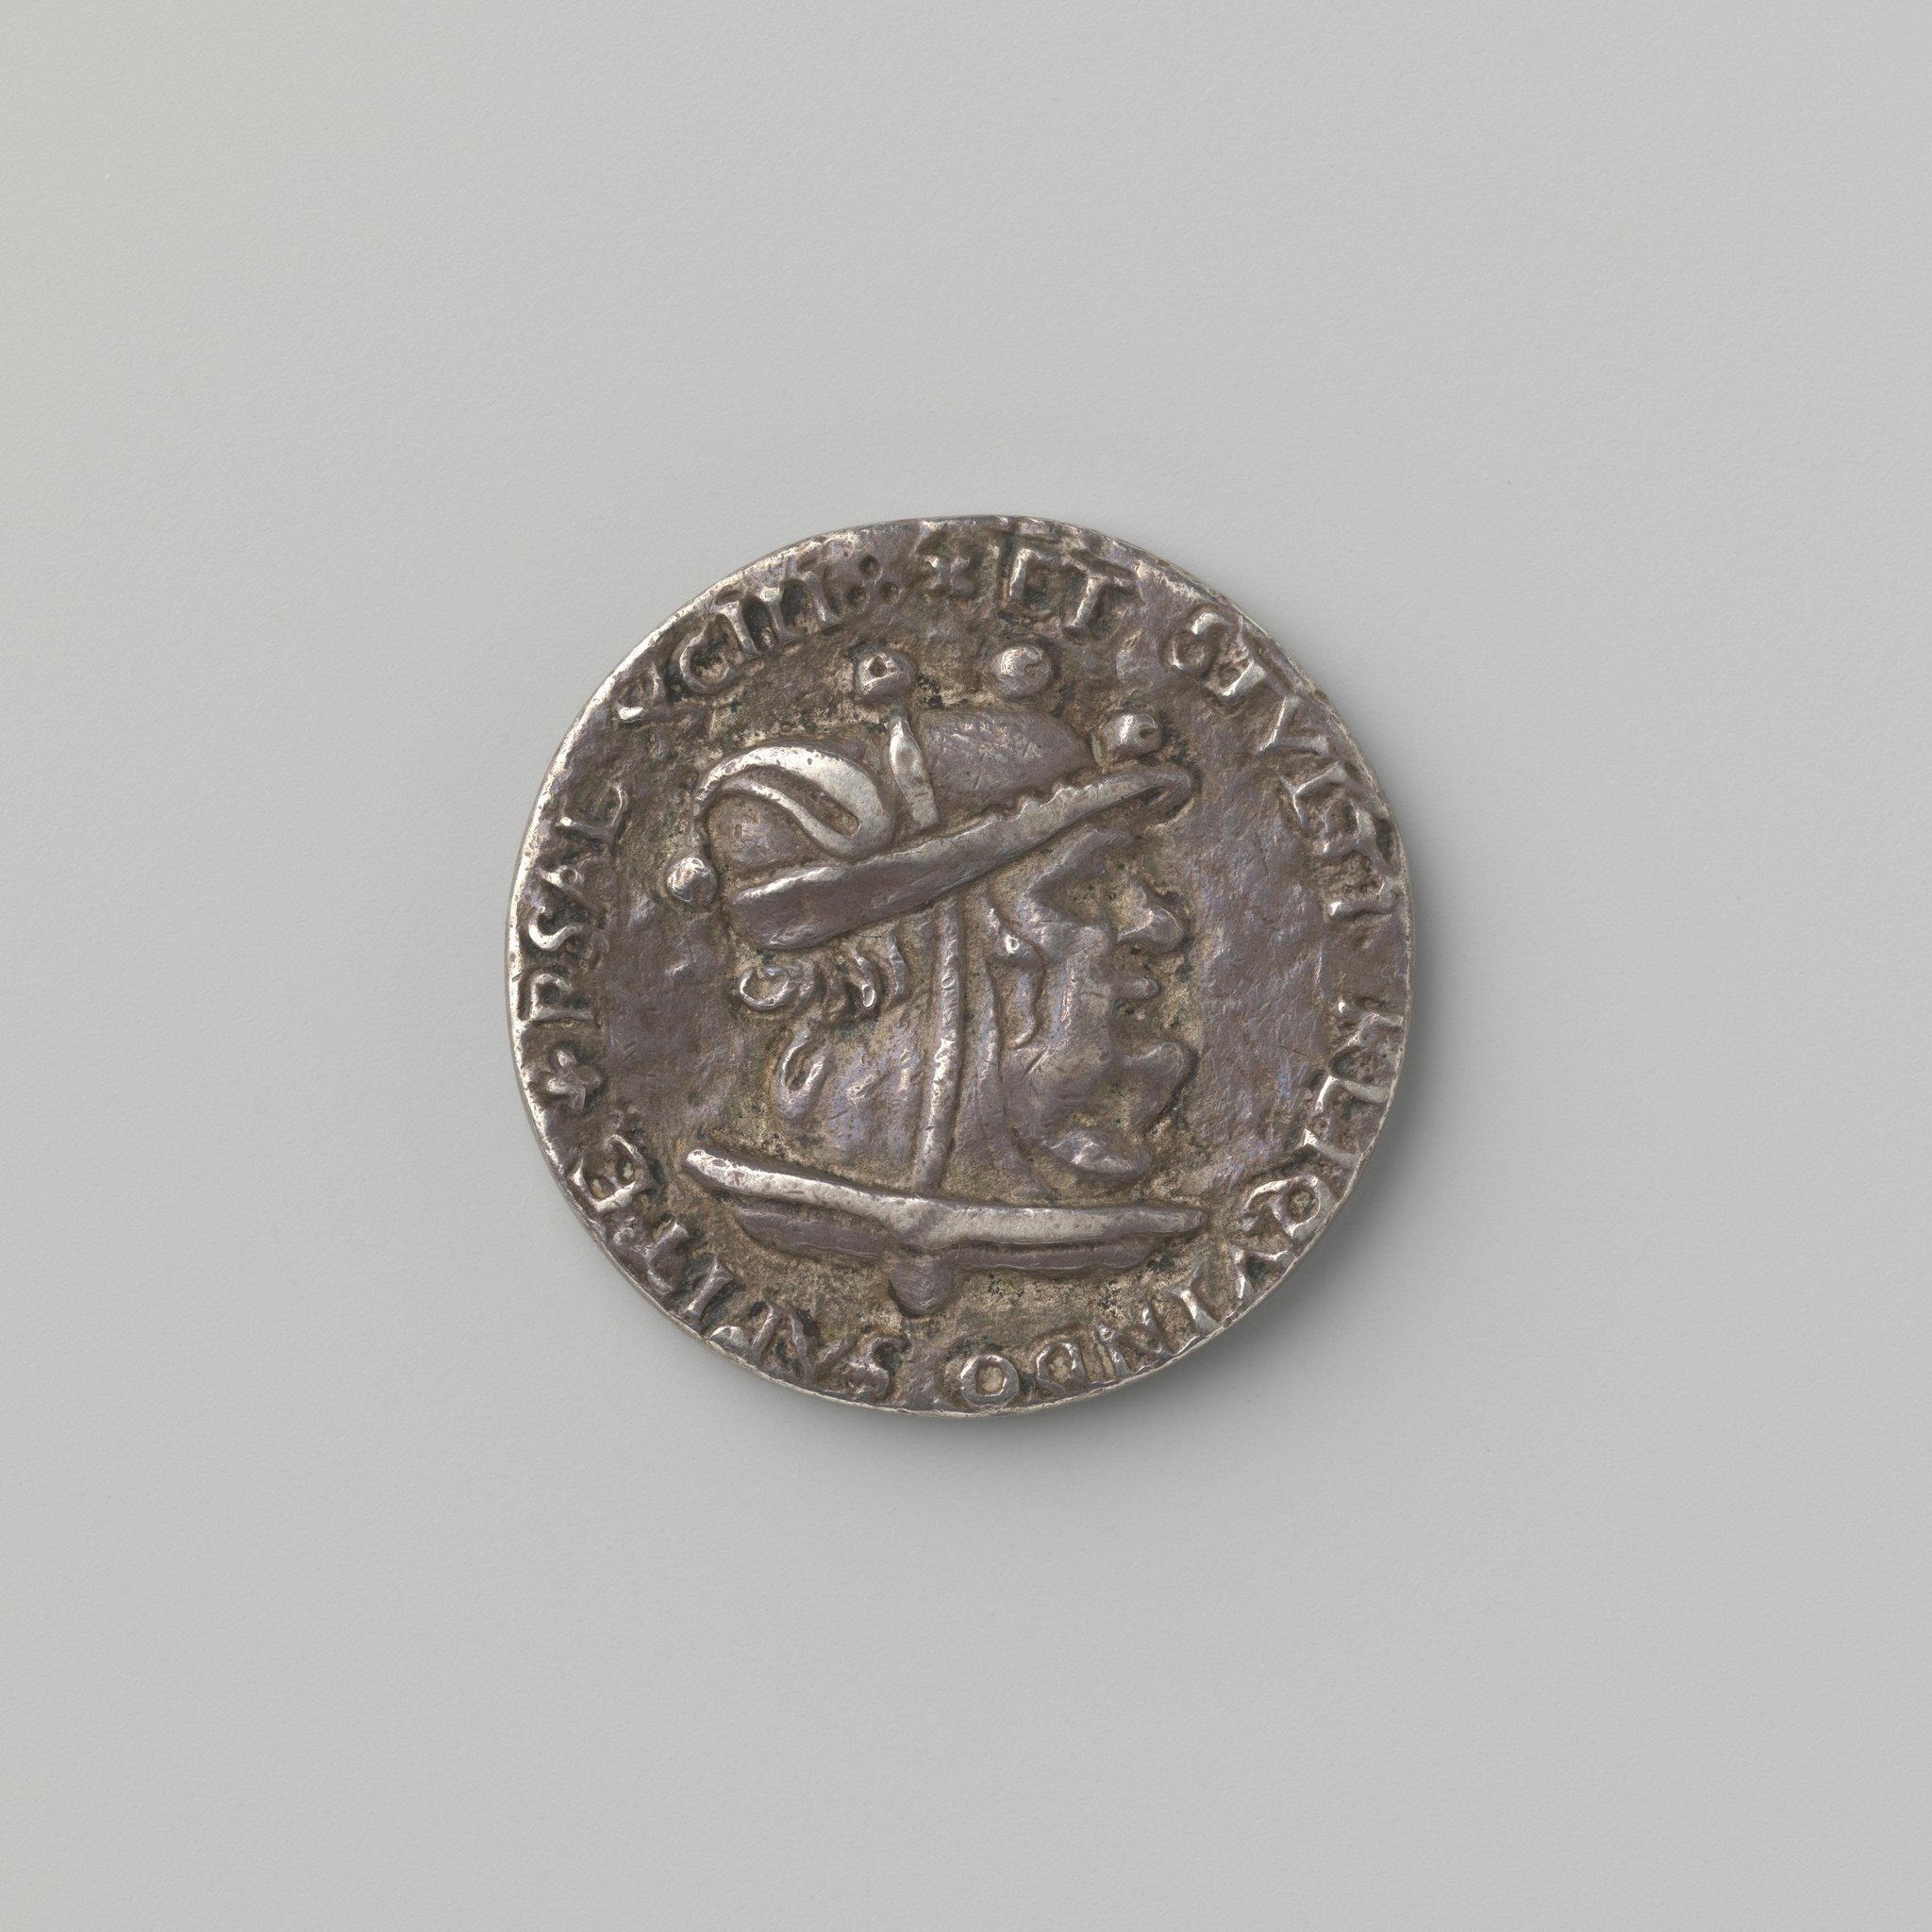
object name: medal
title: Concilie van Trente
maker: Anonymous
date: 1545-1563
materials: silver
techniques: casting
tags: concilie van trente